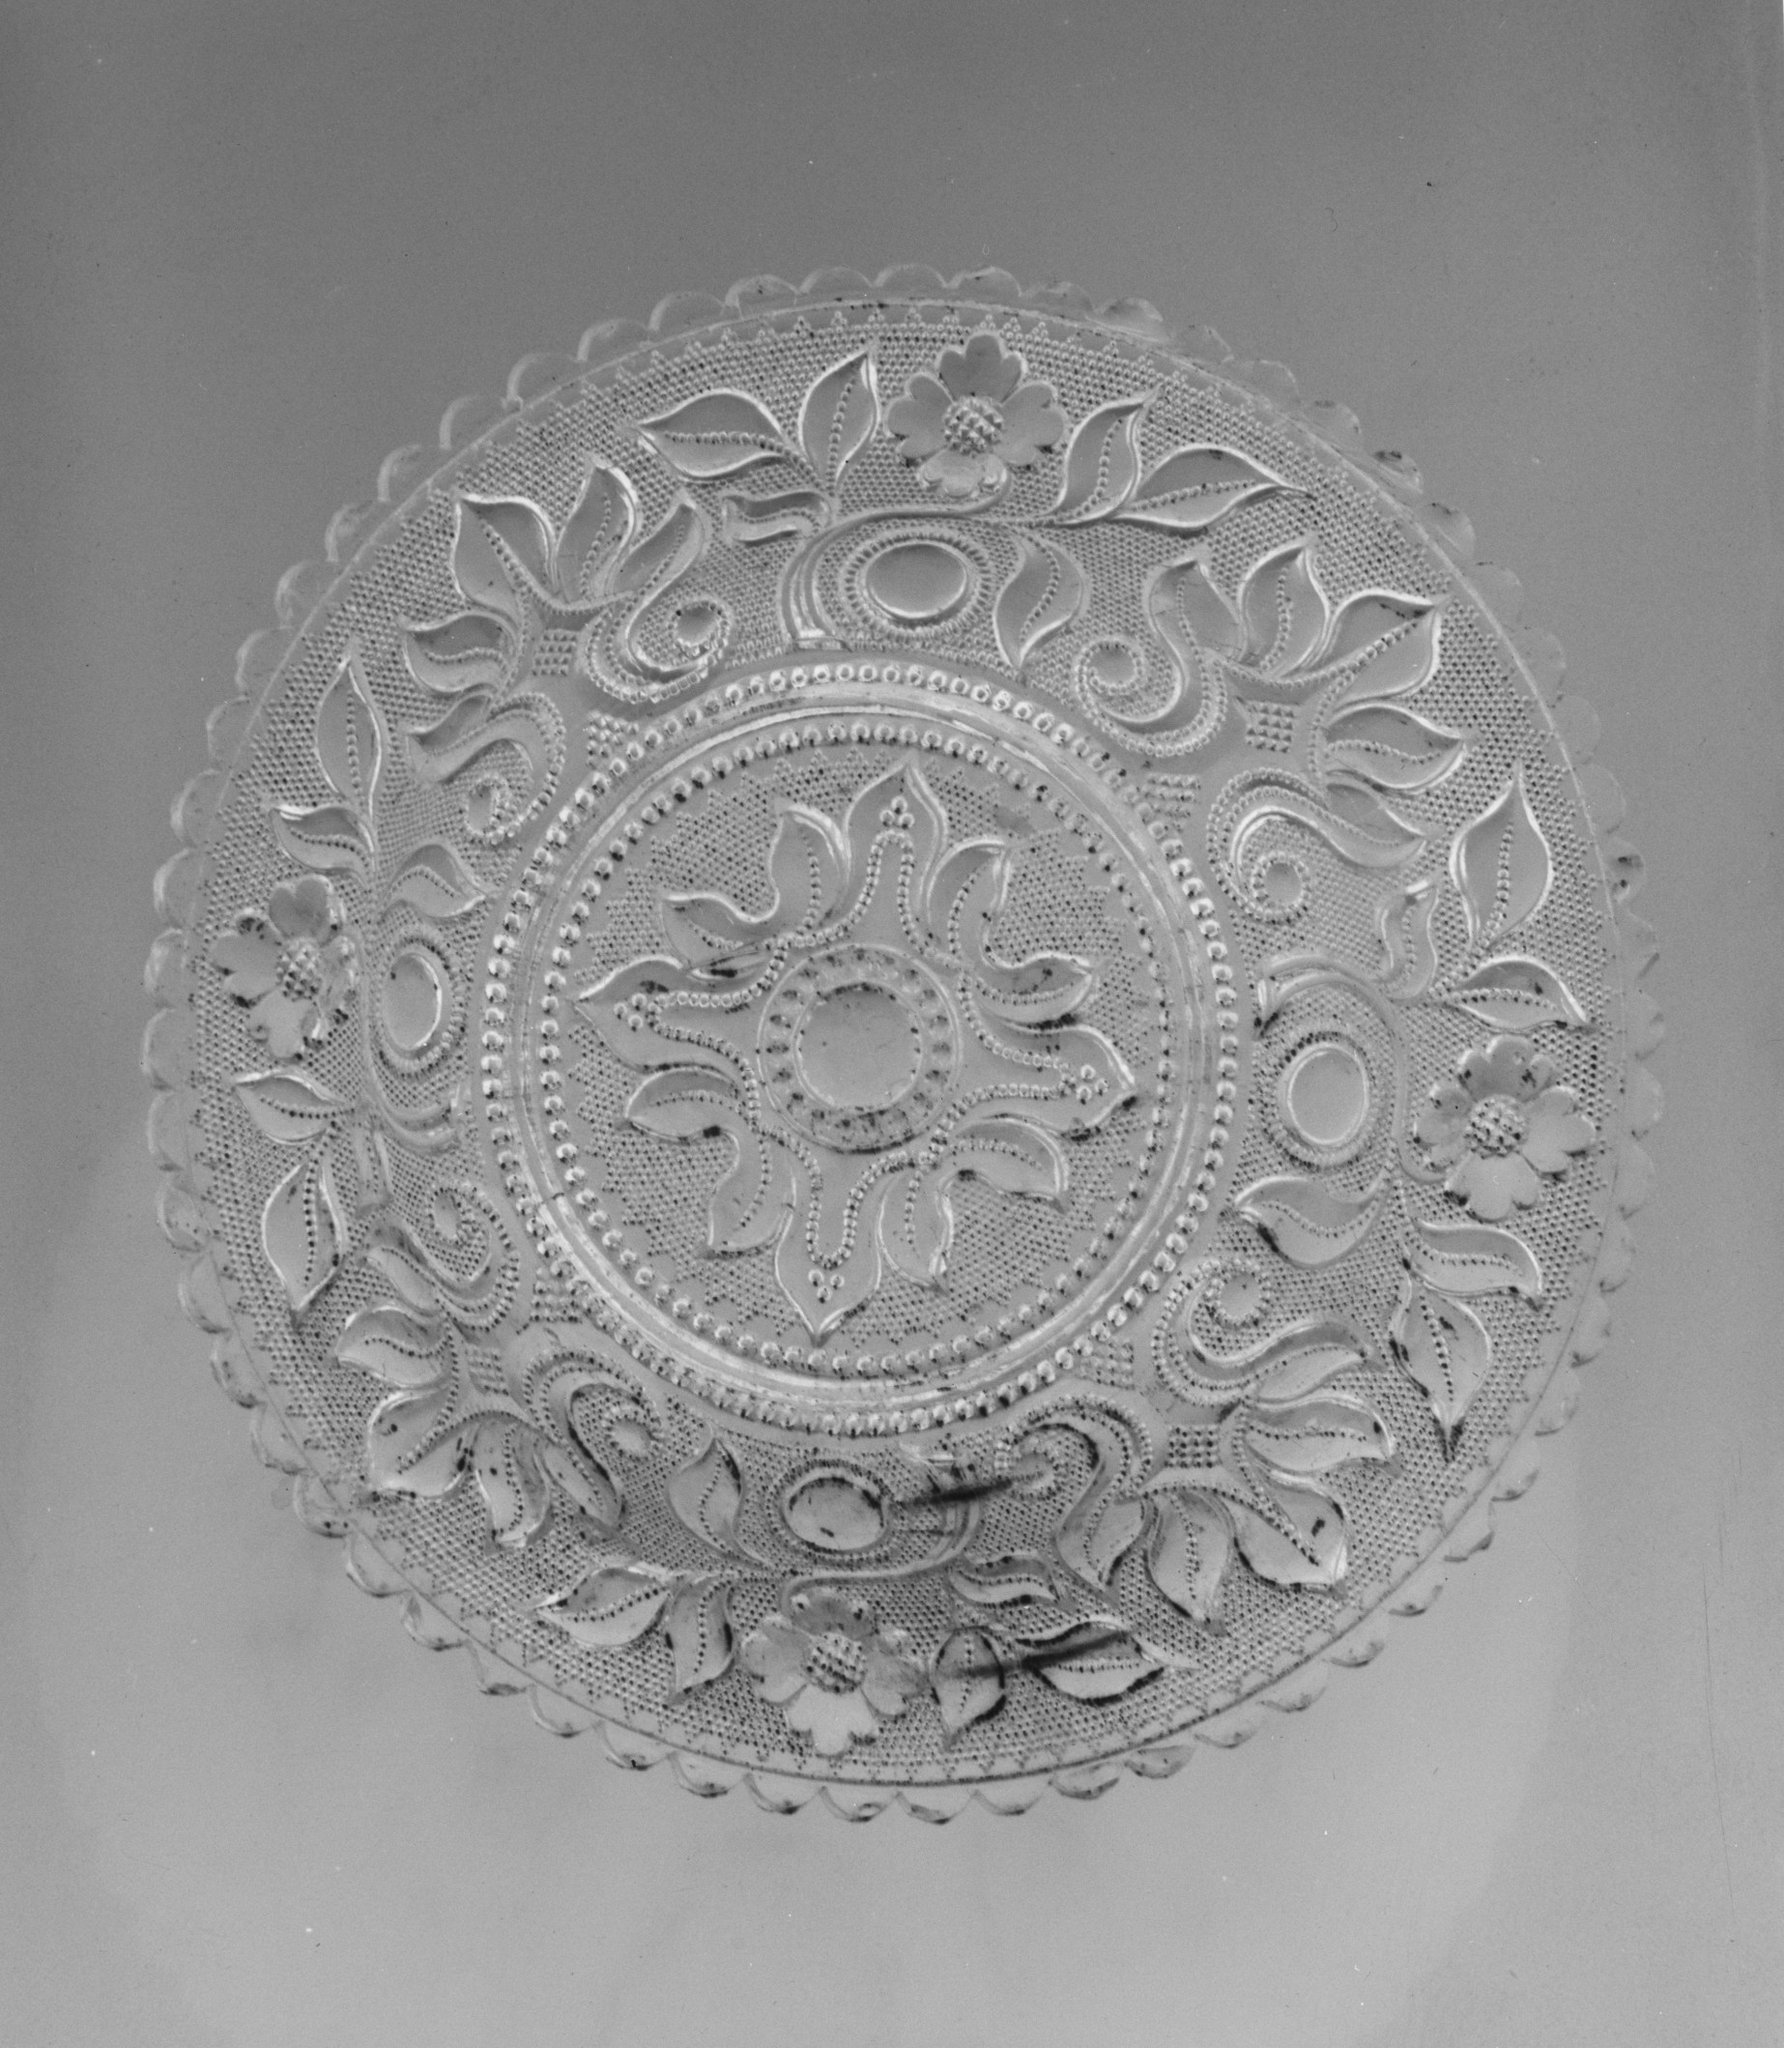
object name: bowl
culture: american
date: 1840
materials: glass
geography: united states